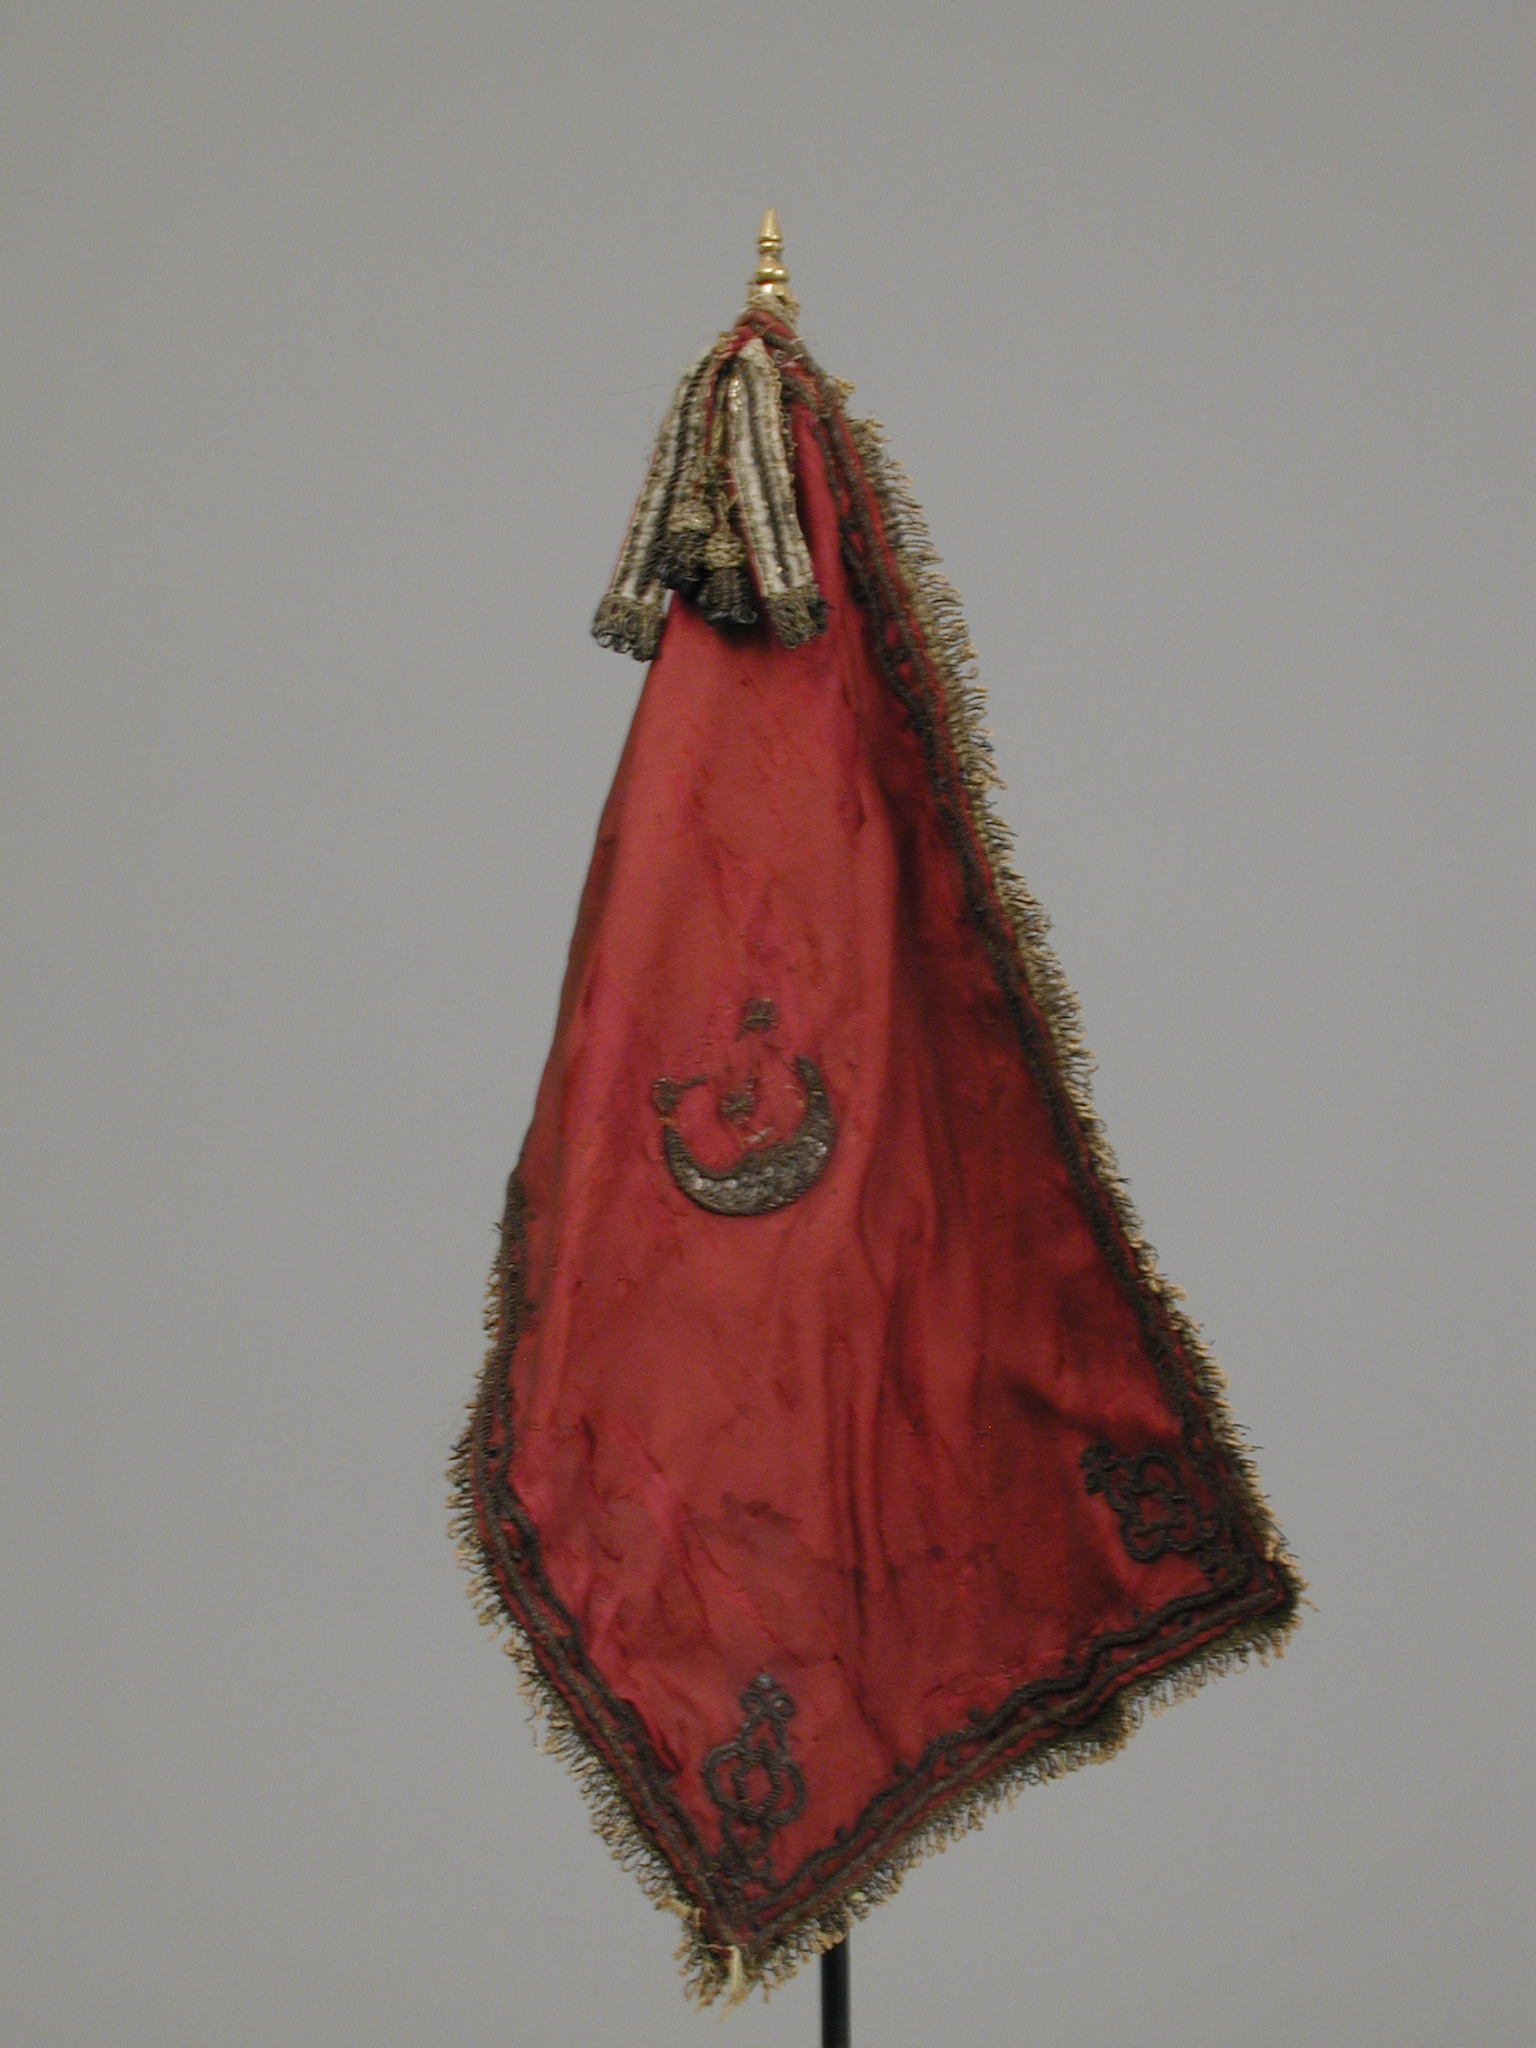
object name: crèche accessory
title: Banner with staff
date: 1701-1800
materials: brass, wood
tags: flags